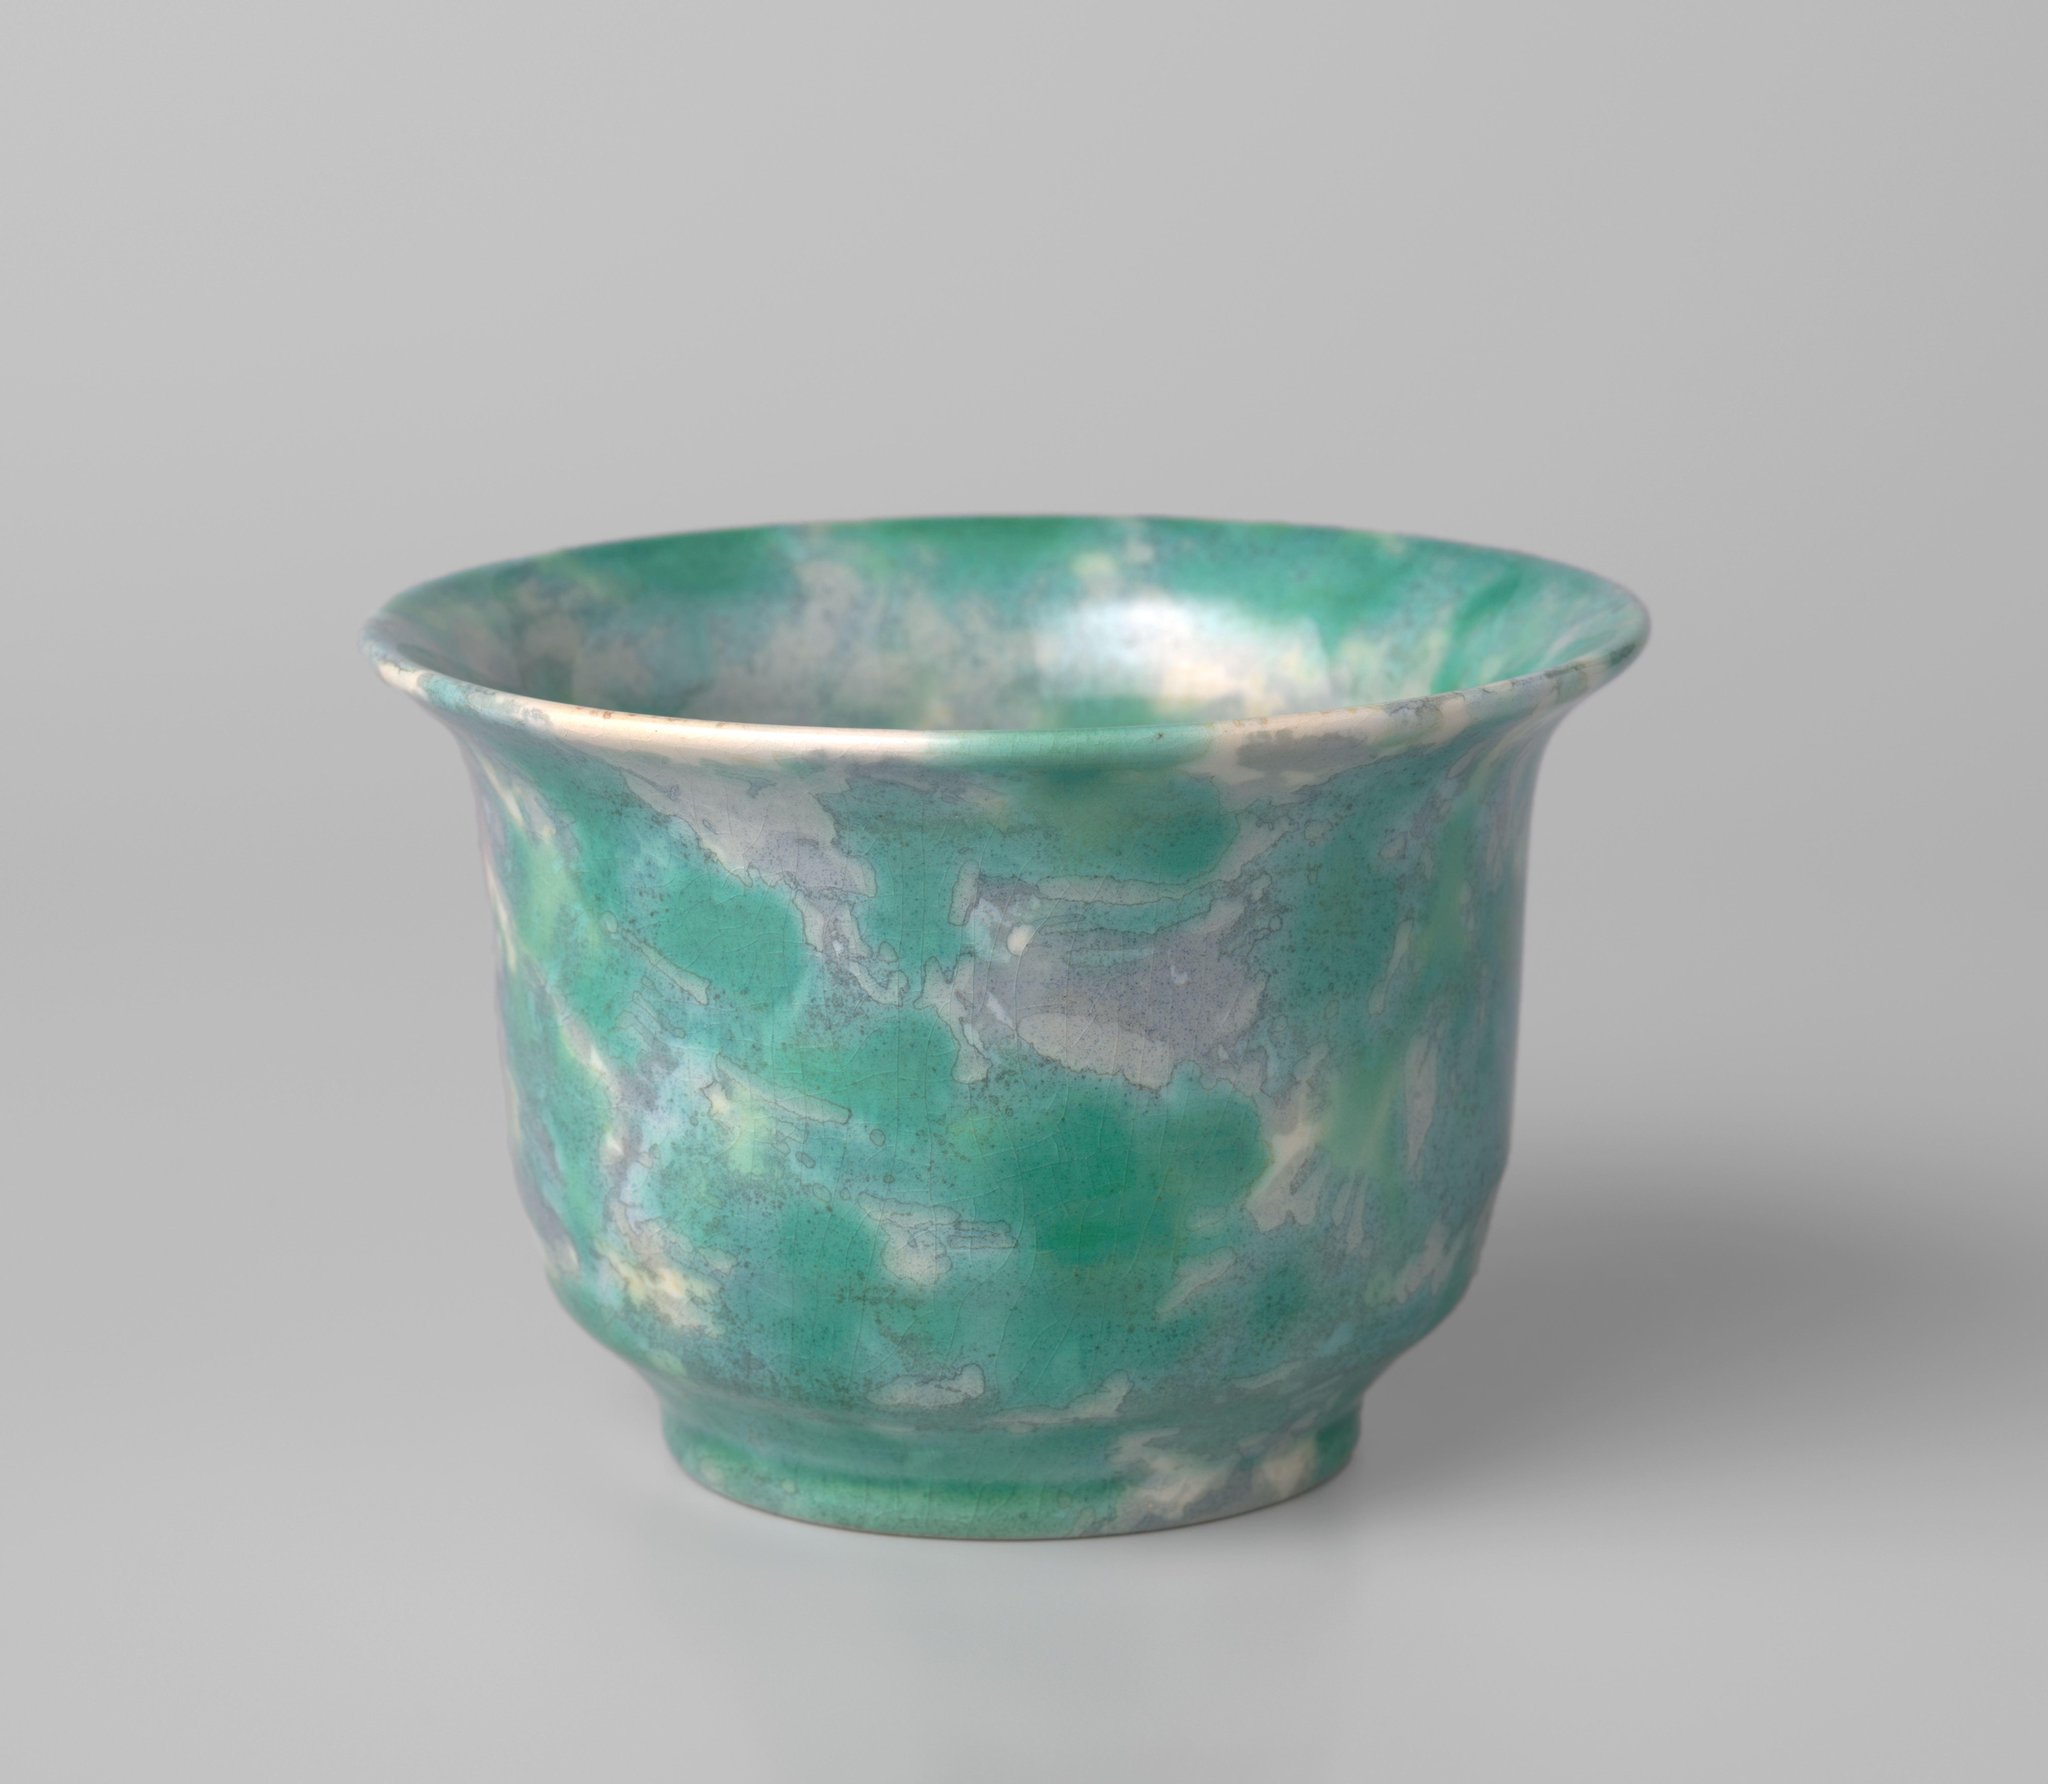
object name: bowl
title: Kom met gemarmerd decor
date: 1925-1930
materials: earthenware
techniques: marbling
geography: arnhem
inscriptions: mark: ‘172 (stempel) ; 12/8 (in zwart)’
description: Kom van aardewerk, met uitstaande mondrand, met een groen, geel en grijs gemarmerd decor. Luxor aardewerk.